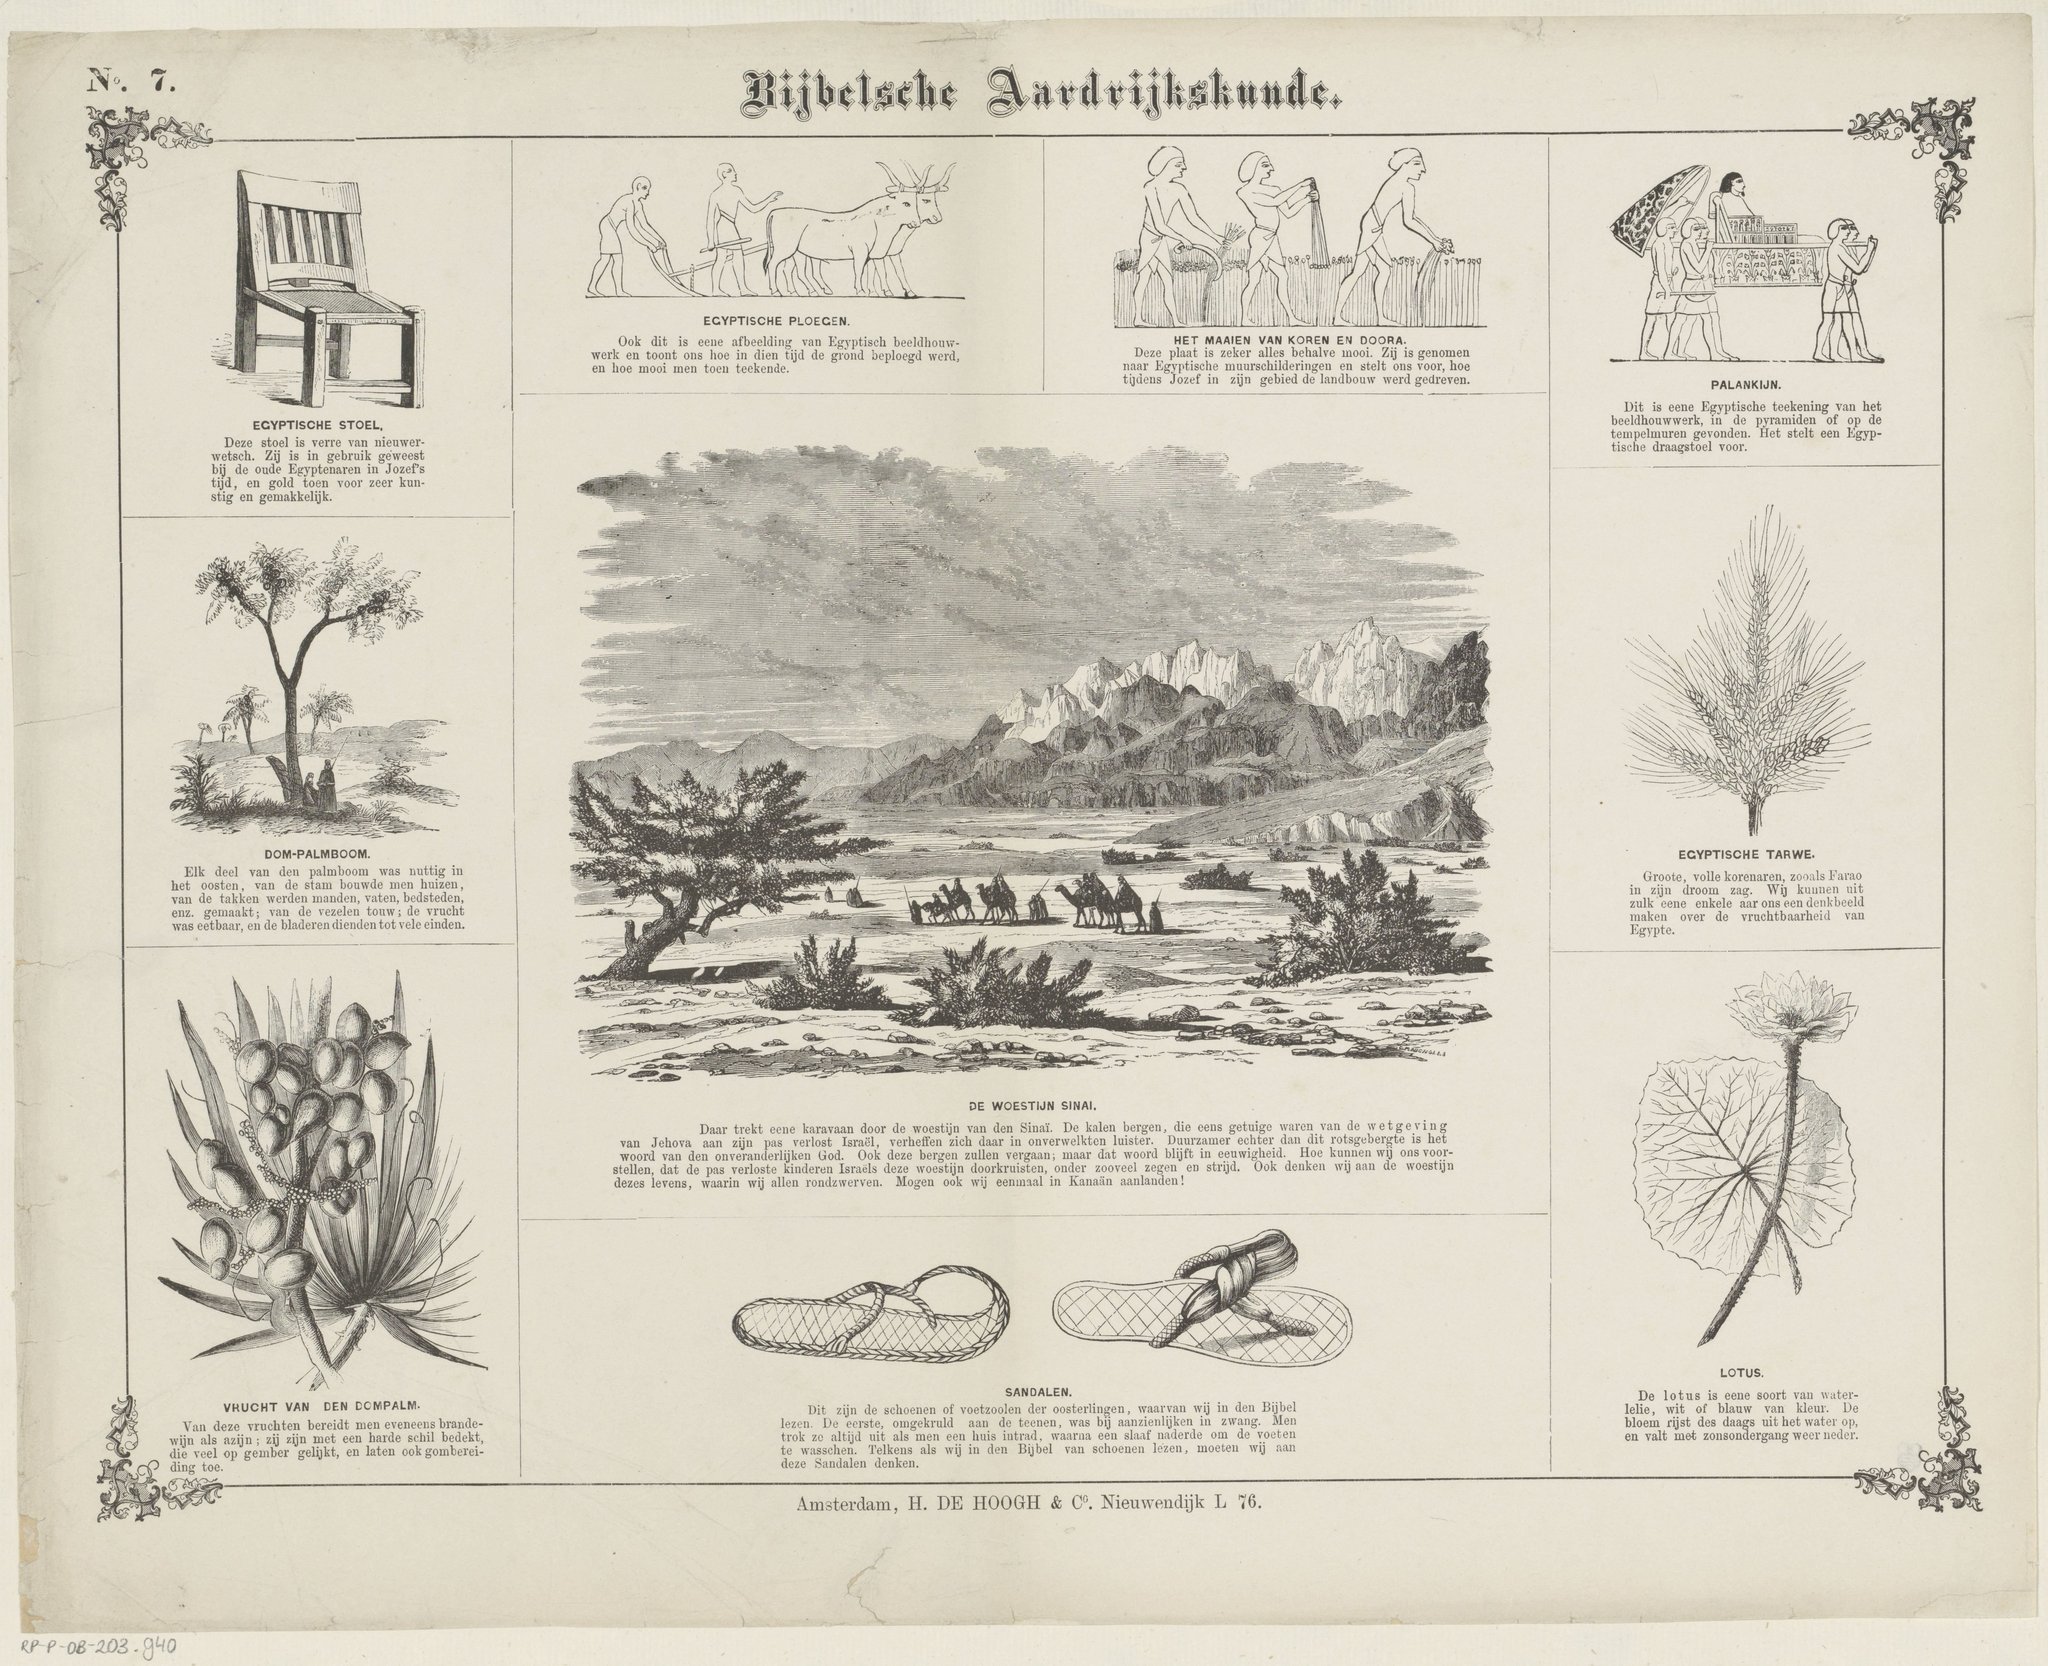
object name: print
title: Bijbelsche aardrijkskunde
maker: Anonymous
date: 1866-1871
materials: paper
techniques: letterpress printing, engraving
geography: amsterdam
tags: plants; vegetation, piece of sculpture, reproduction of a piece of sculpture, shoes, sandals, trees: palm-tree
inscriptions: collector's mark: Lugt 2760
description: Blad met 10 voorstellingen van voorwerpen, planten, Egyptische sculptuur en de Sinaïwoestijn. Onder elke afbeelding een onderschrift. Genummerd linksboven: No. 7.